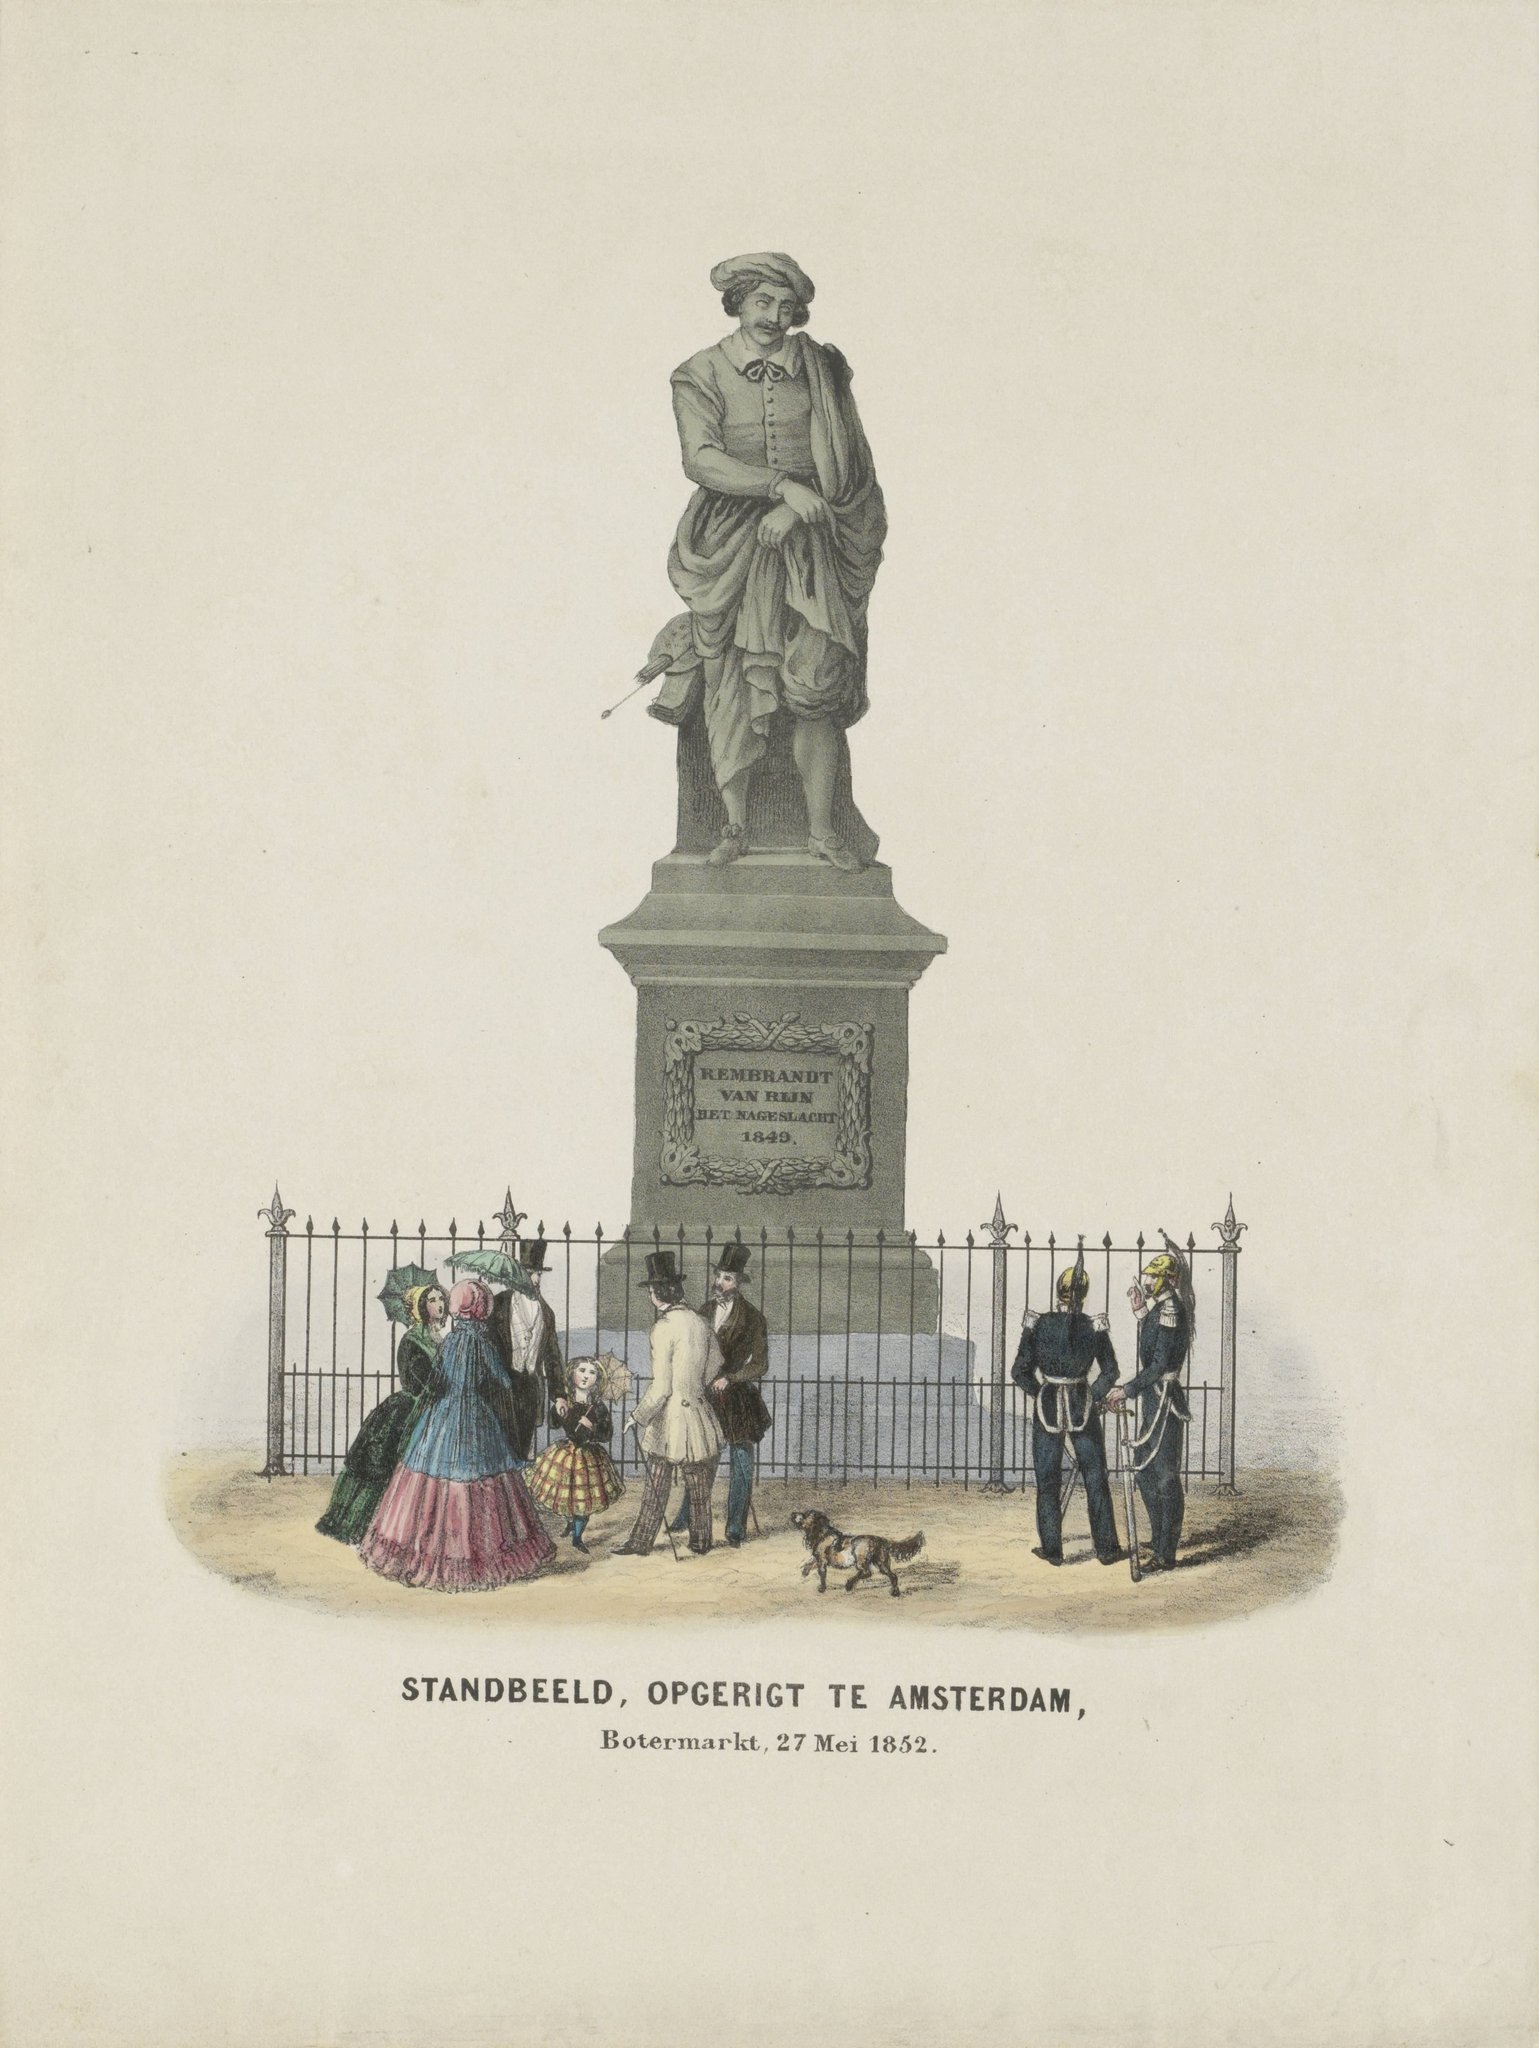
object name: print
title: Standbeeld, opgerigt te Amsterdam, Botermarkt, 27 Mei 1852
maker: Anonymous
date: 1852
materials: paper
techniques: hand coloring, lacquer, lithograph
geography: netherlands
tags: leiden, amsterdam, painter, print maker, draughtsman, rembrandt van rijn, monument, statue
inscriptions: collector's mark: Lugt 2233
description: Het standbeeld van Rembrandt op het toenmalige Botermarkt, nu (sinds 1876) Rembrandtplein, onthuld op 27 mei 1852. Met verschillende bezoekers, rechts twee kurassiers.